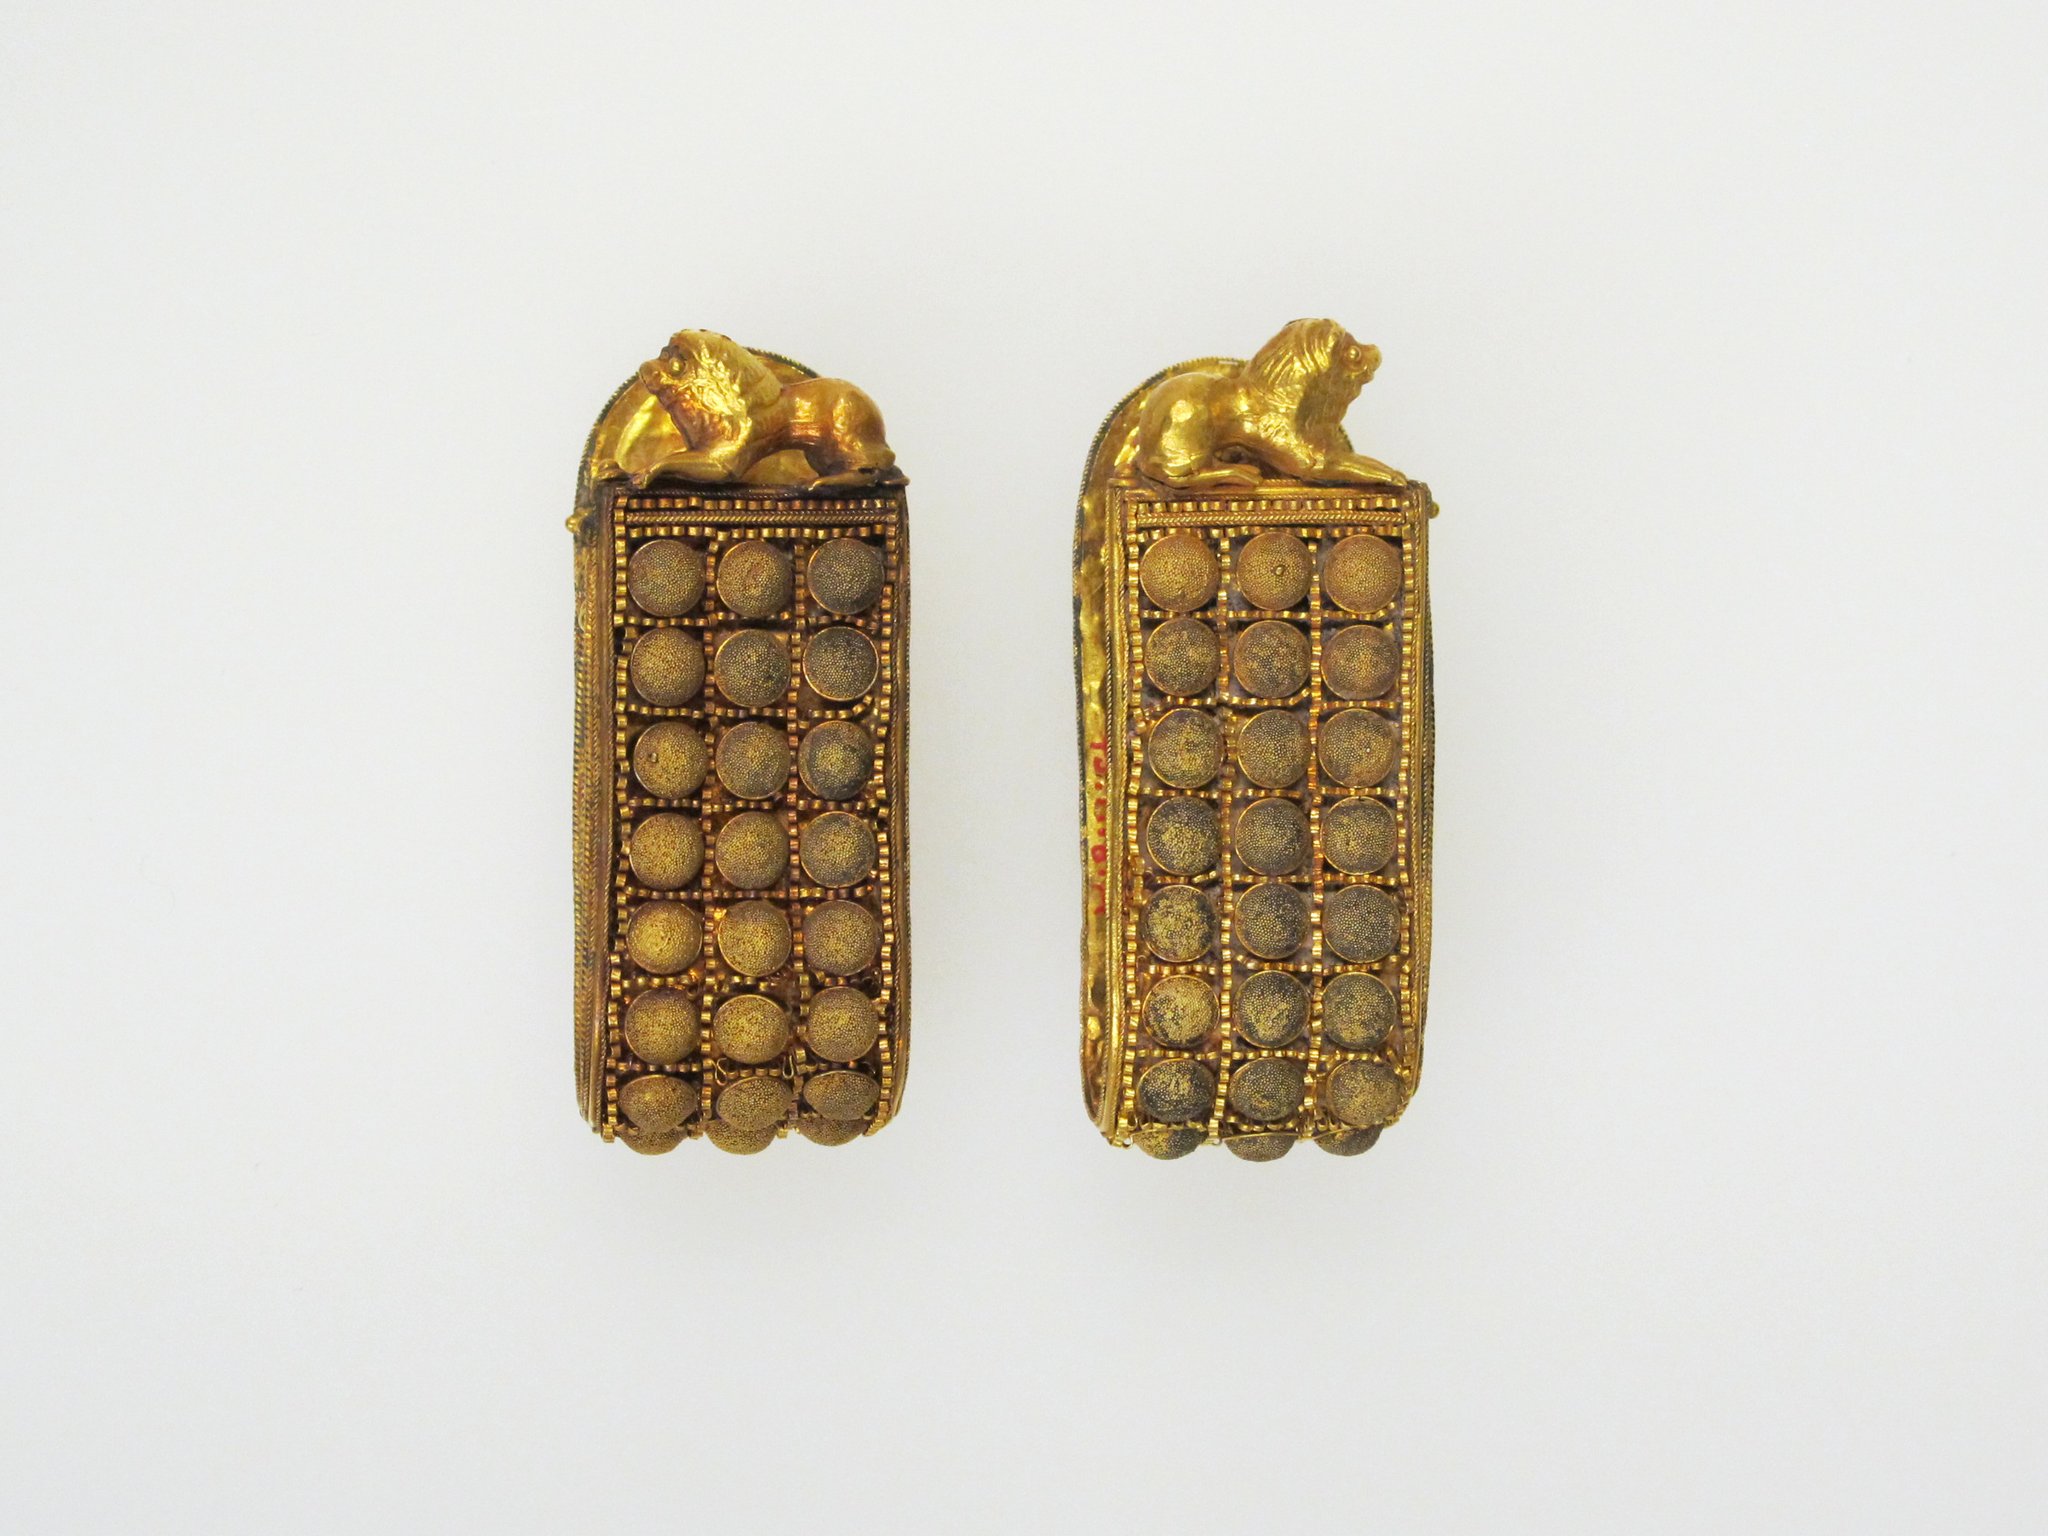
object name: earring, baule type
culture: etruscan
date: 500-401 BCE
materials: gold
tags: lions